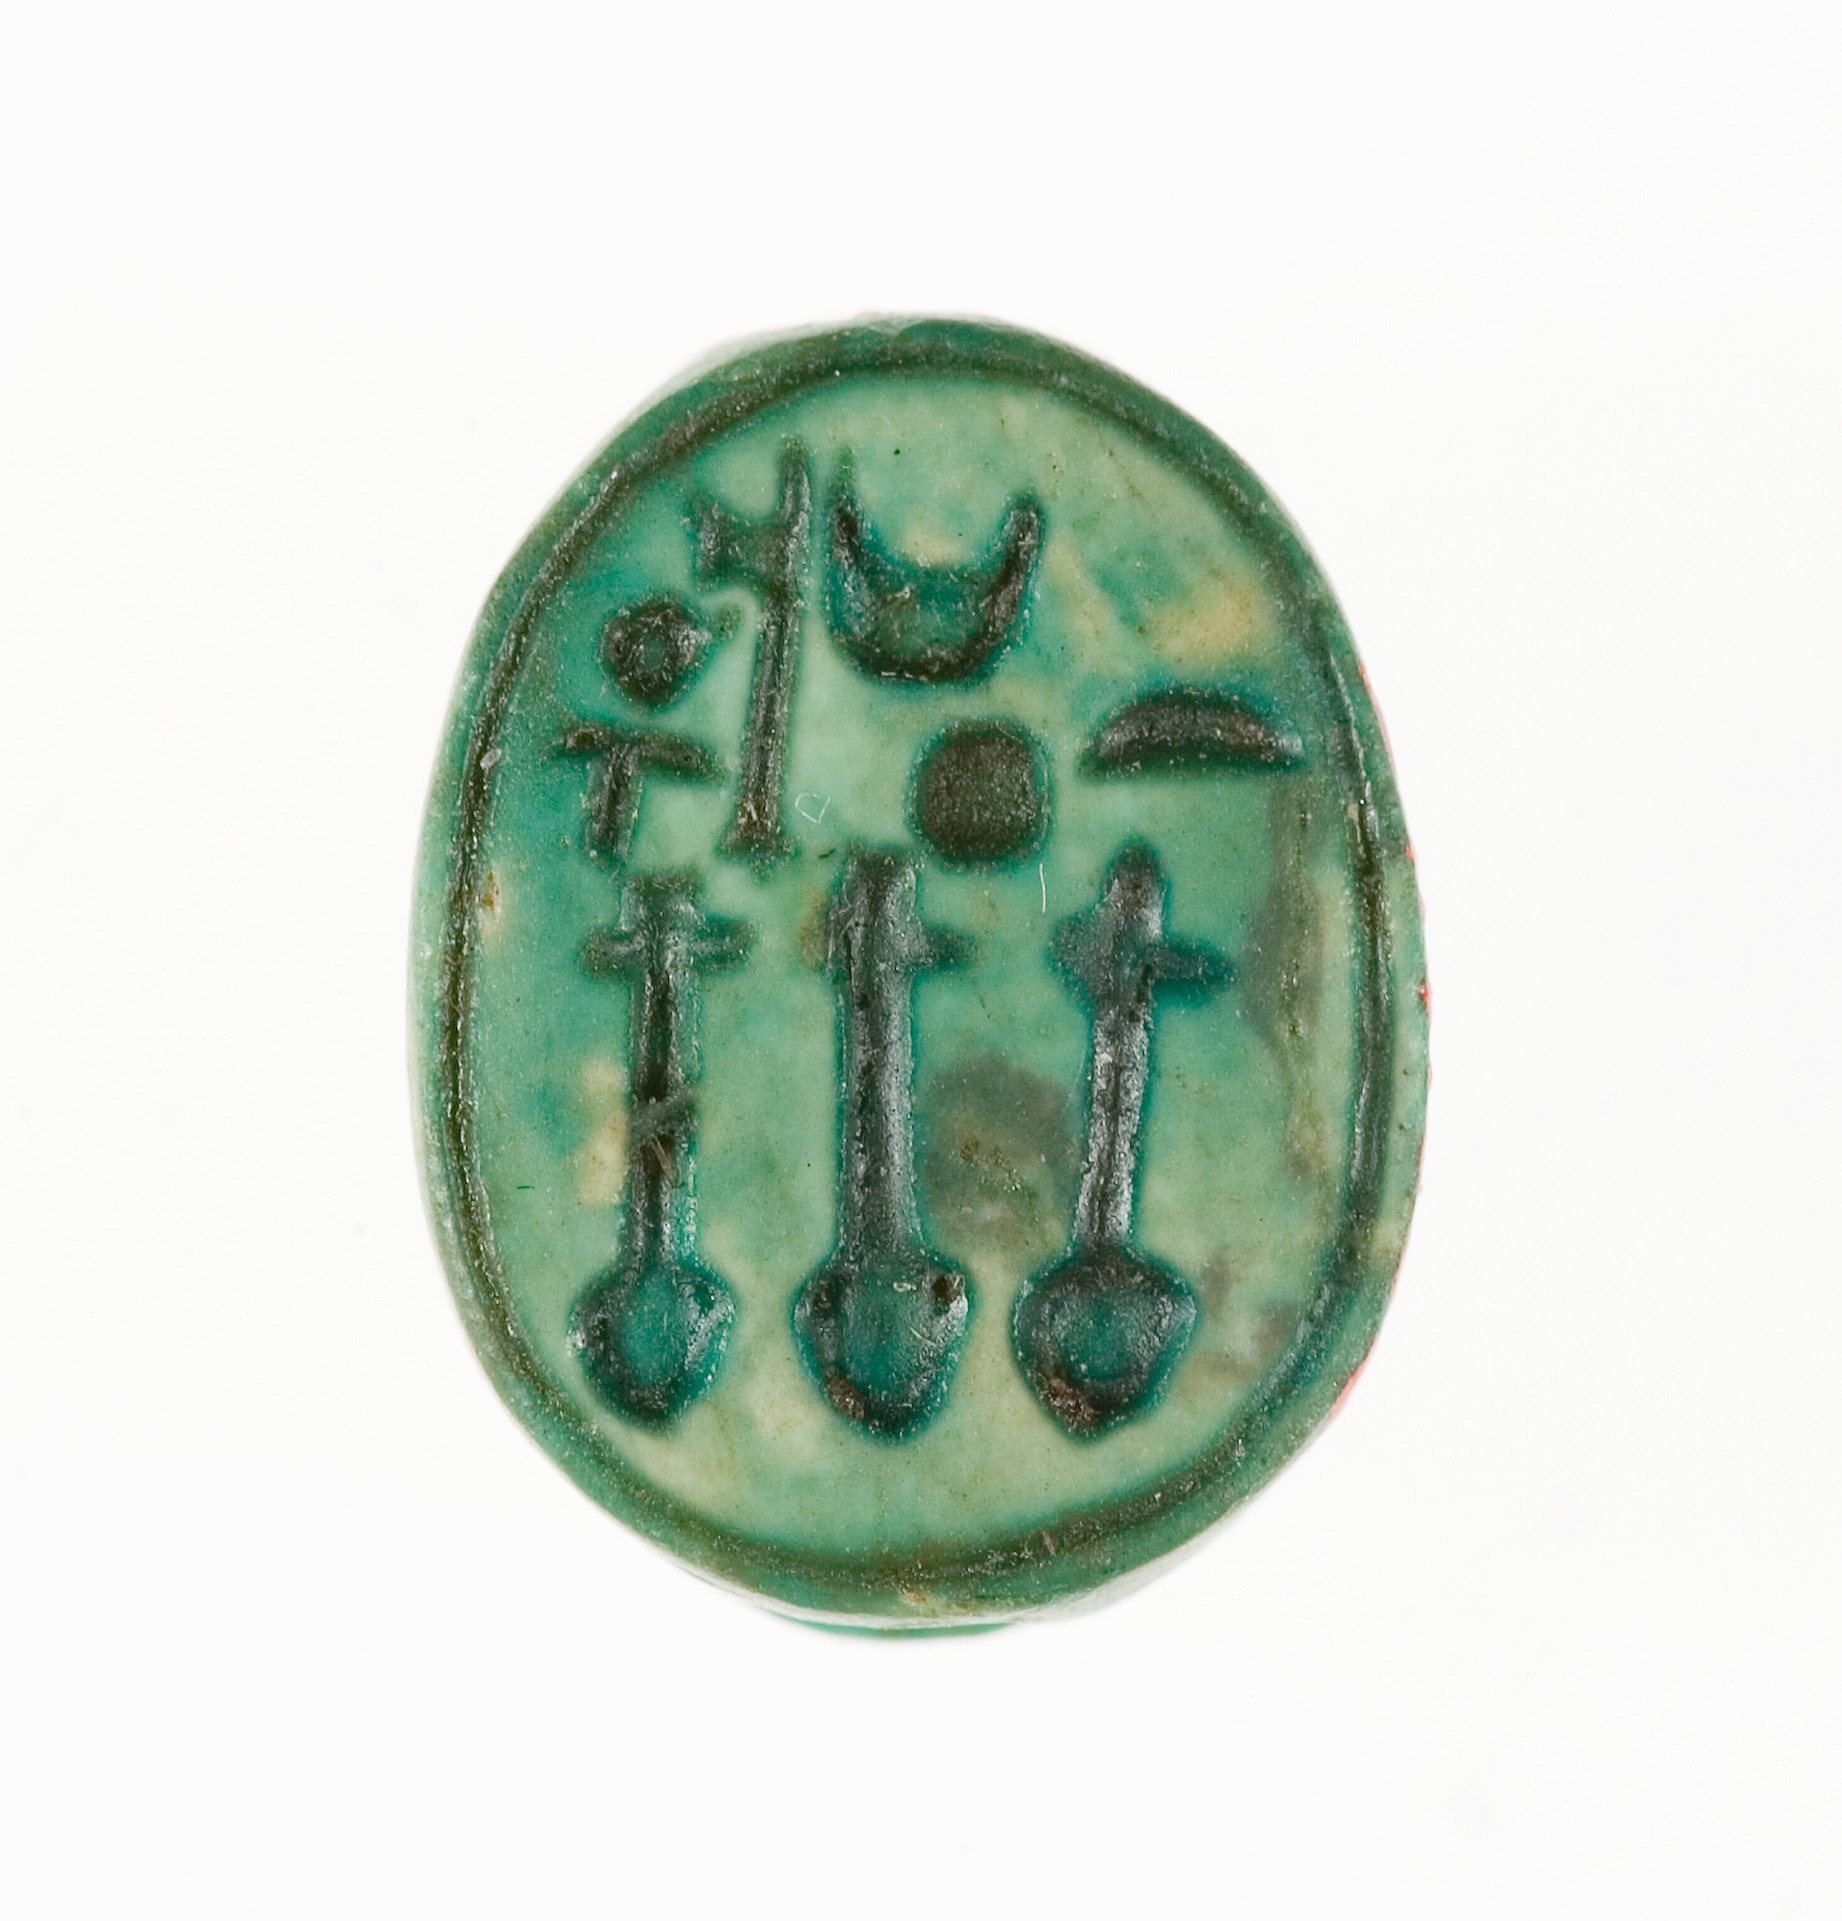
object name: scarab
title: Scarabs Inscribed for the God's Wife Neferure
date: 1479-1458 BCE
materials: stone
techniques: glazing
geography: egypt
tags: hieroglyphs,scarabs